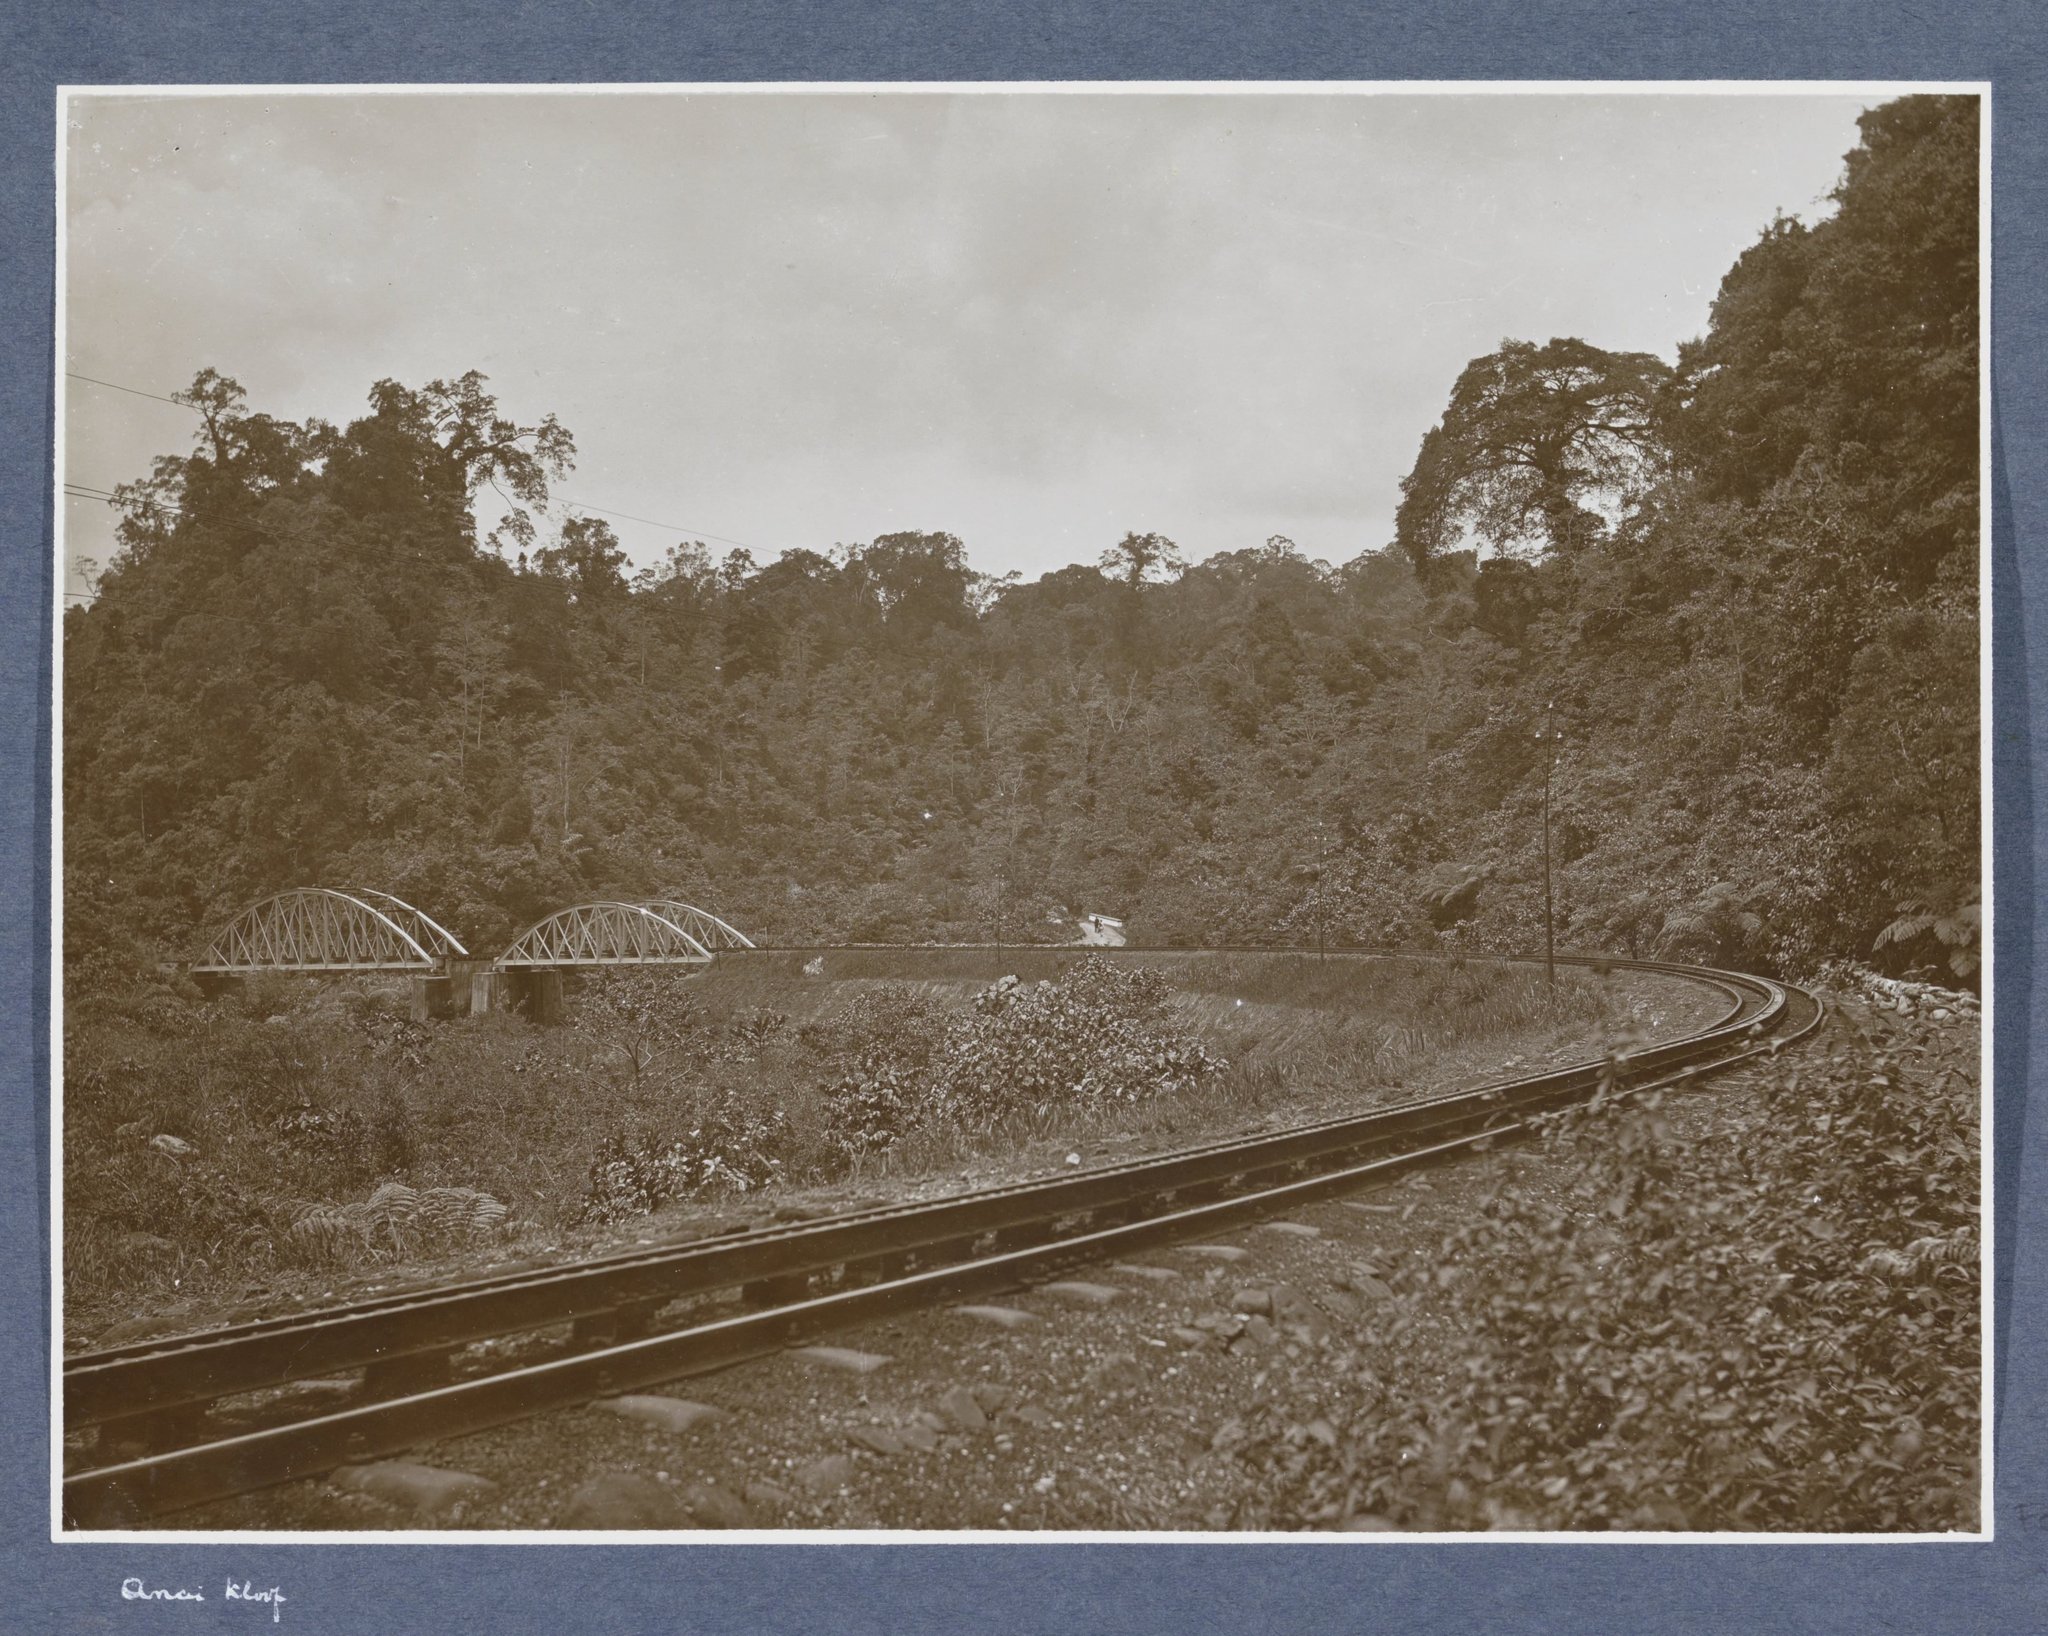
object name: photograph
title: Tandradspoorweg en spoorbrug in de Anaikloof op Sumatra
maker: christiaan benjamin nieuwenhuis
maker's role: publisher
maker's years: 1863-1922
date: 1900-1920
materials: paper, photographic support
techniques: gelatin silver print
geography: sumatra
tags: funicular railway, landscape with bridge, viaduct or aqueduct, ravine, chasm, abyss, canyon, railway, train, sumatra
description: Onderdeel van reisalbum met foto's van bedrijvigheid en bezienswaardigheden op Sumatra en Java en van de reis naar en van Nederlands-Indië.